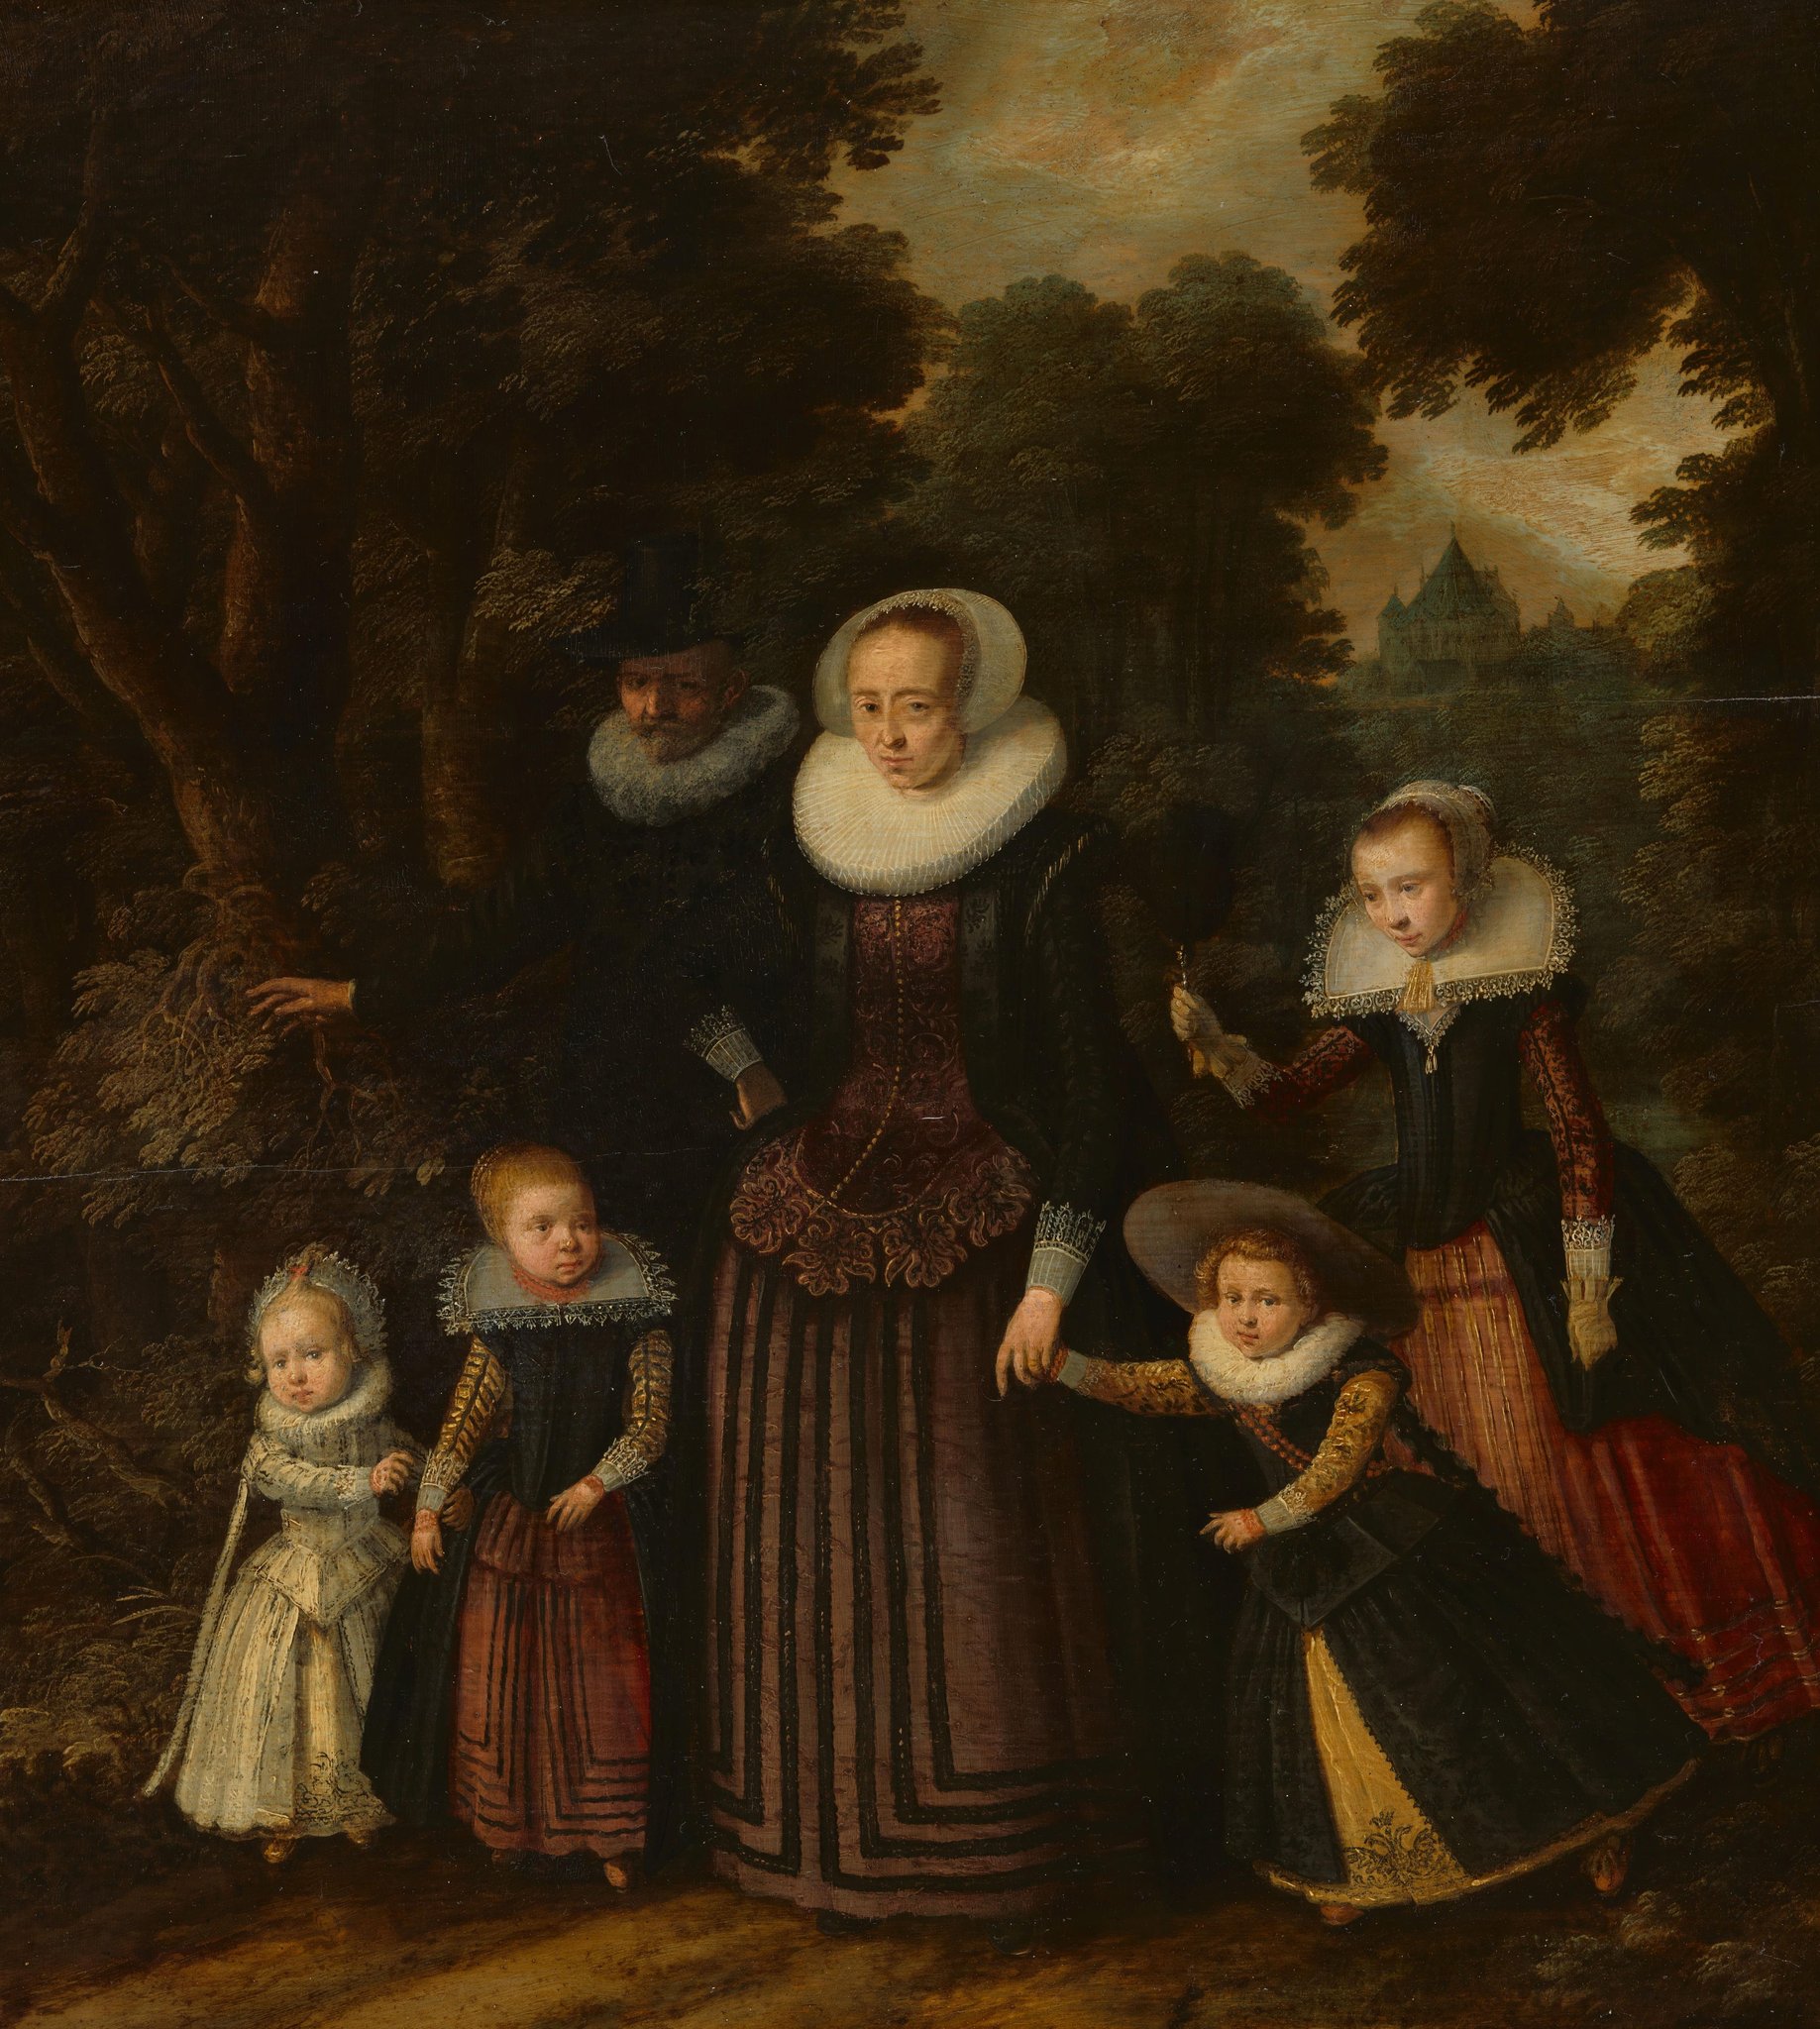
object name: painting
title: Portrait of a Couple and Four Children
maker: Anonymous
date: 1620-1625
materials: oil, panel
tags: family group, especially parents with their child(ren), anonymous historical persons portrayed in a group, in a group-portrait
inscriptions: monogram, bottom left, falsely signed: ‘TDK’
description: Familieportret van een echtpaar met vier kinderen staande ten voeten uit tussen de bomen van een bos of park achter een buitenhuis. De oudste dochter rechts houdt een veren waaier omhoog.